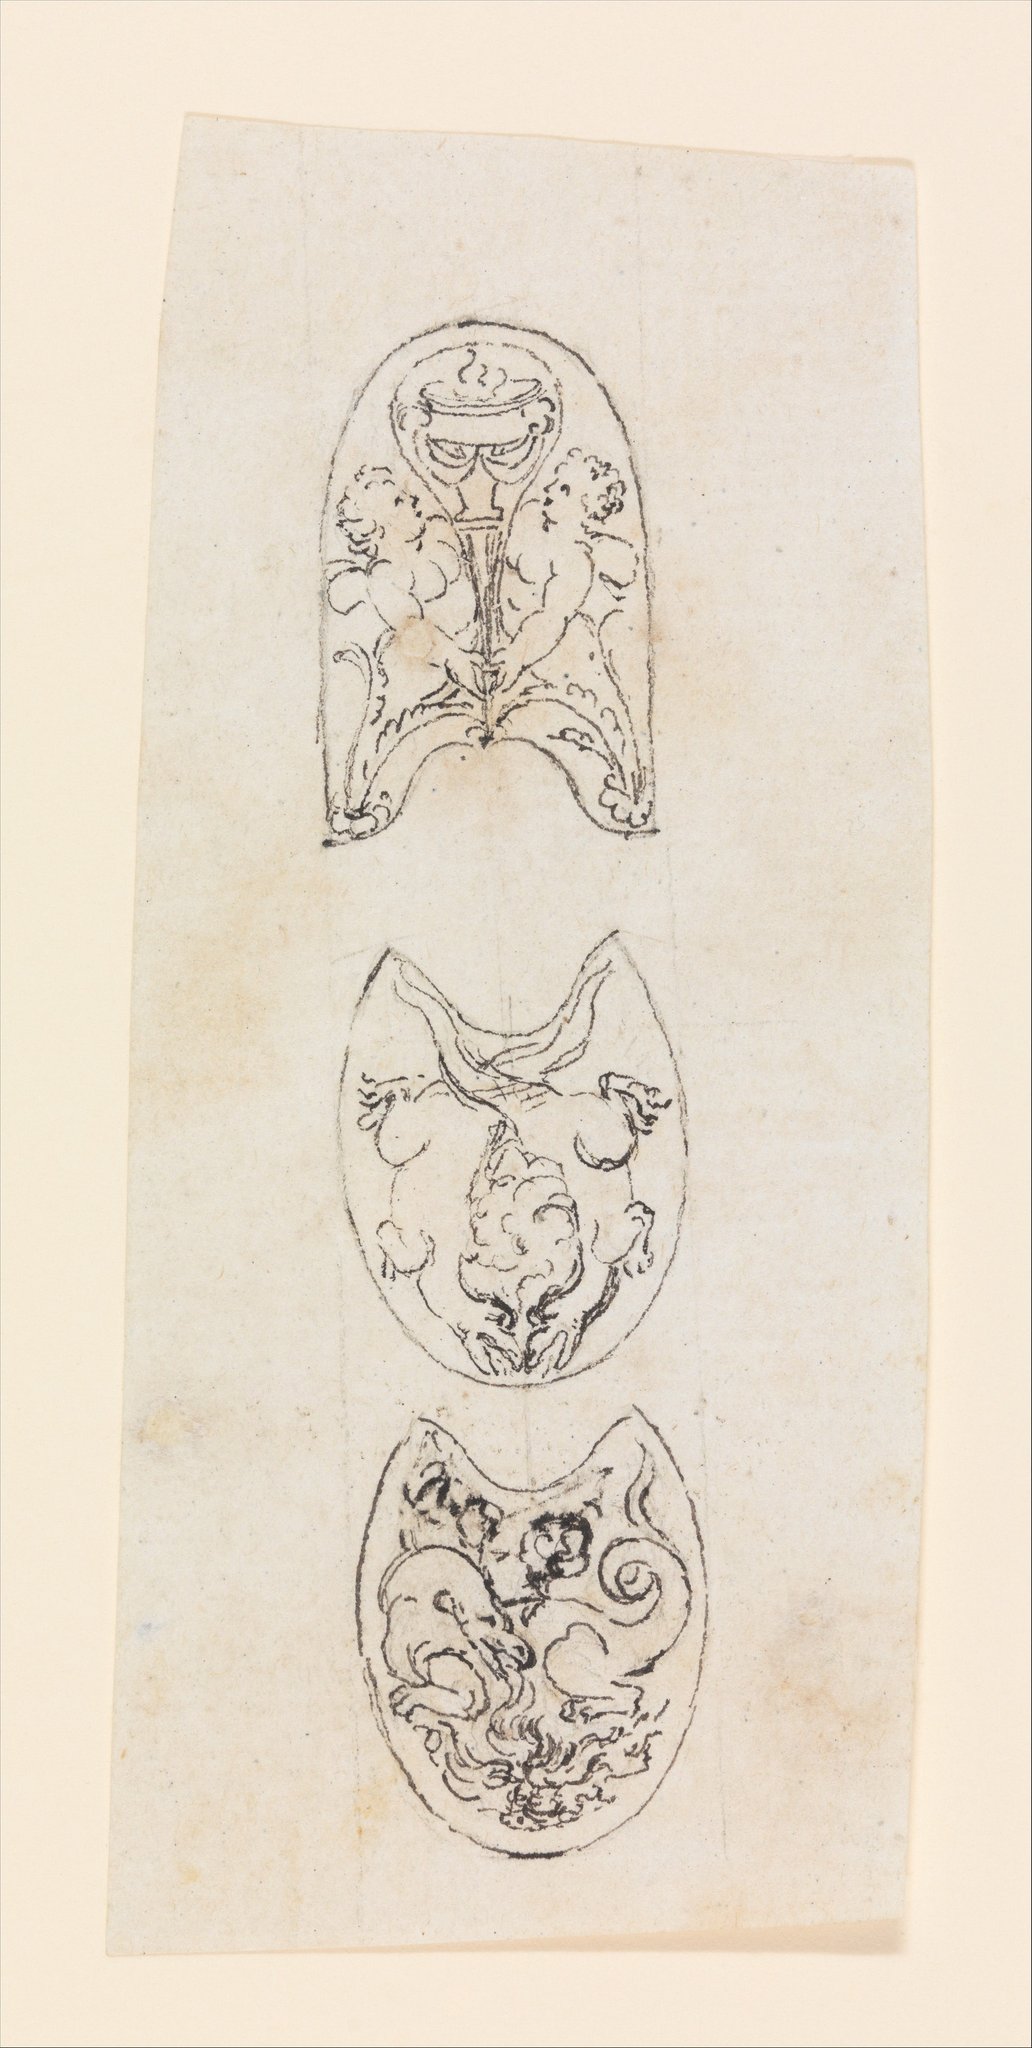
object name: drawing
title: Designs for the Decoration of the Frizzen and Jaws of the Cock of a Firearm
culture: french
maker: nicolas noël boutet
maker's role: designer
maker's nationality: french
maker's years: 1761-1833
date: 1797-1805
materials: ink, paper, pencil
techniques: wash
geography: france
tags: ornament